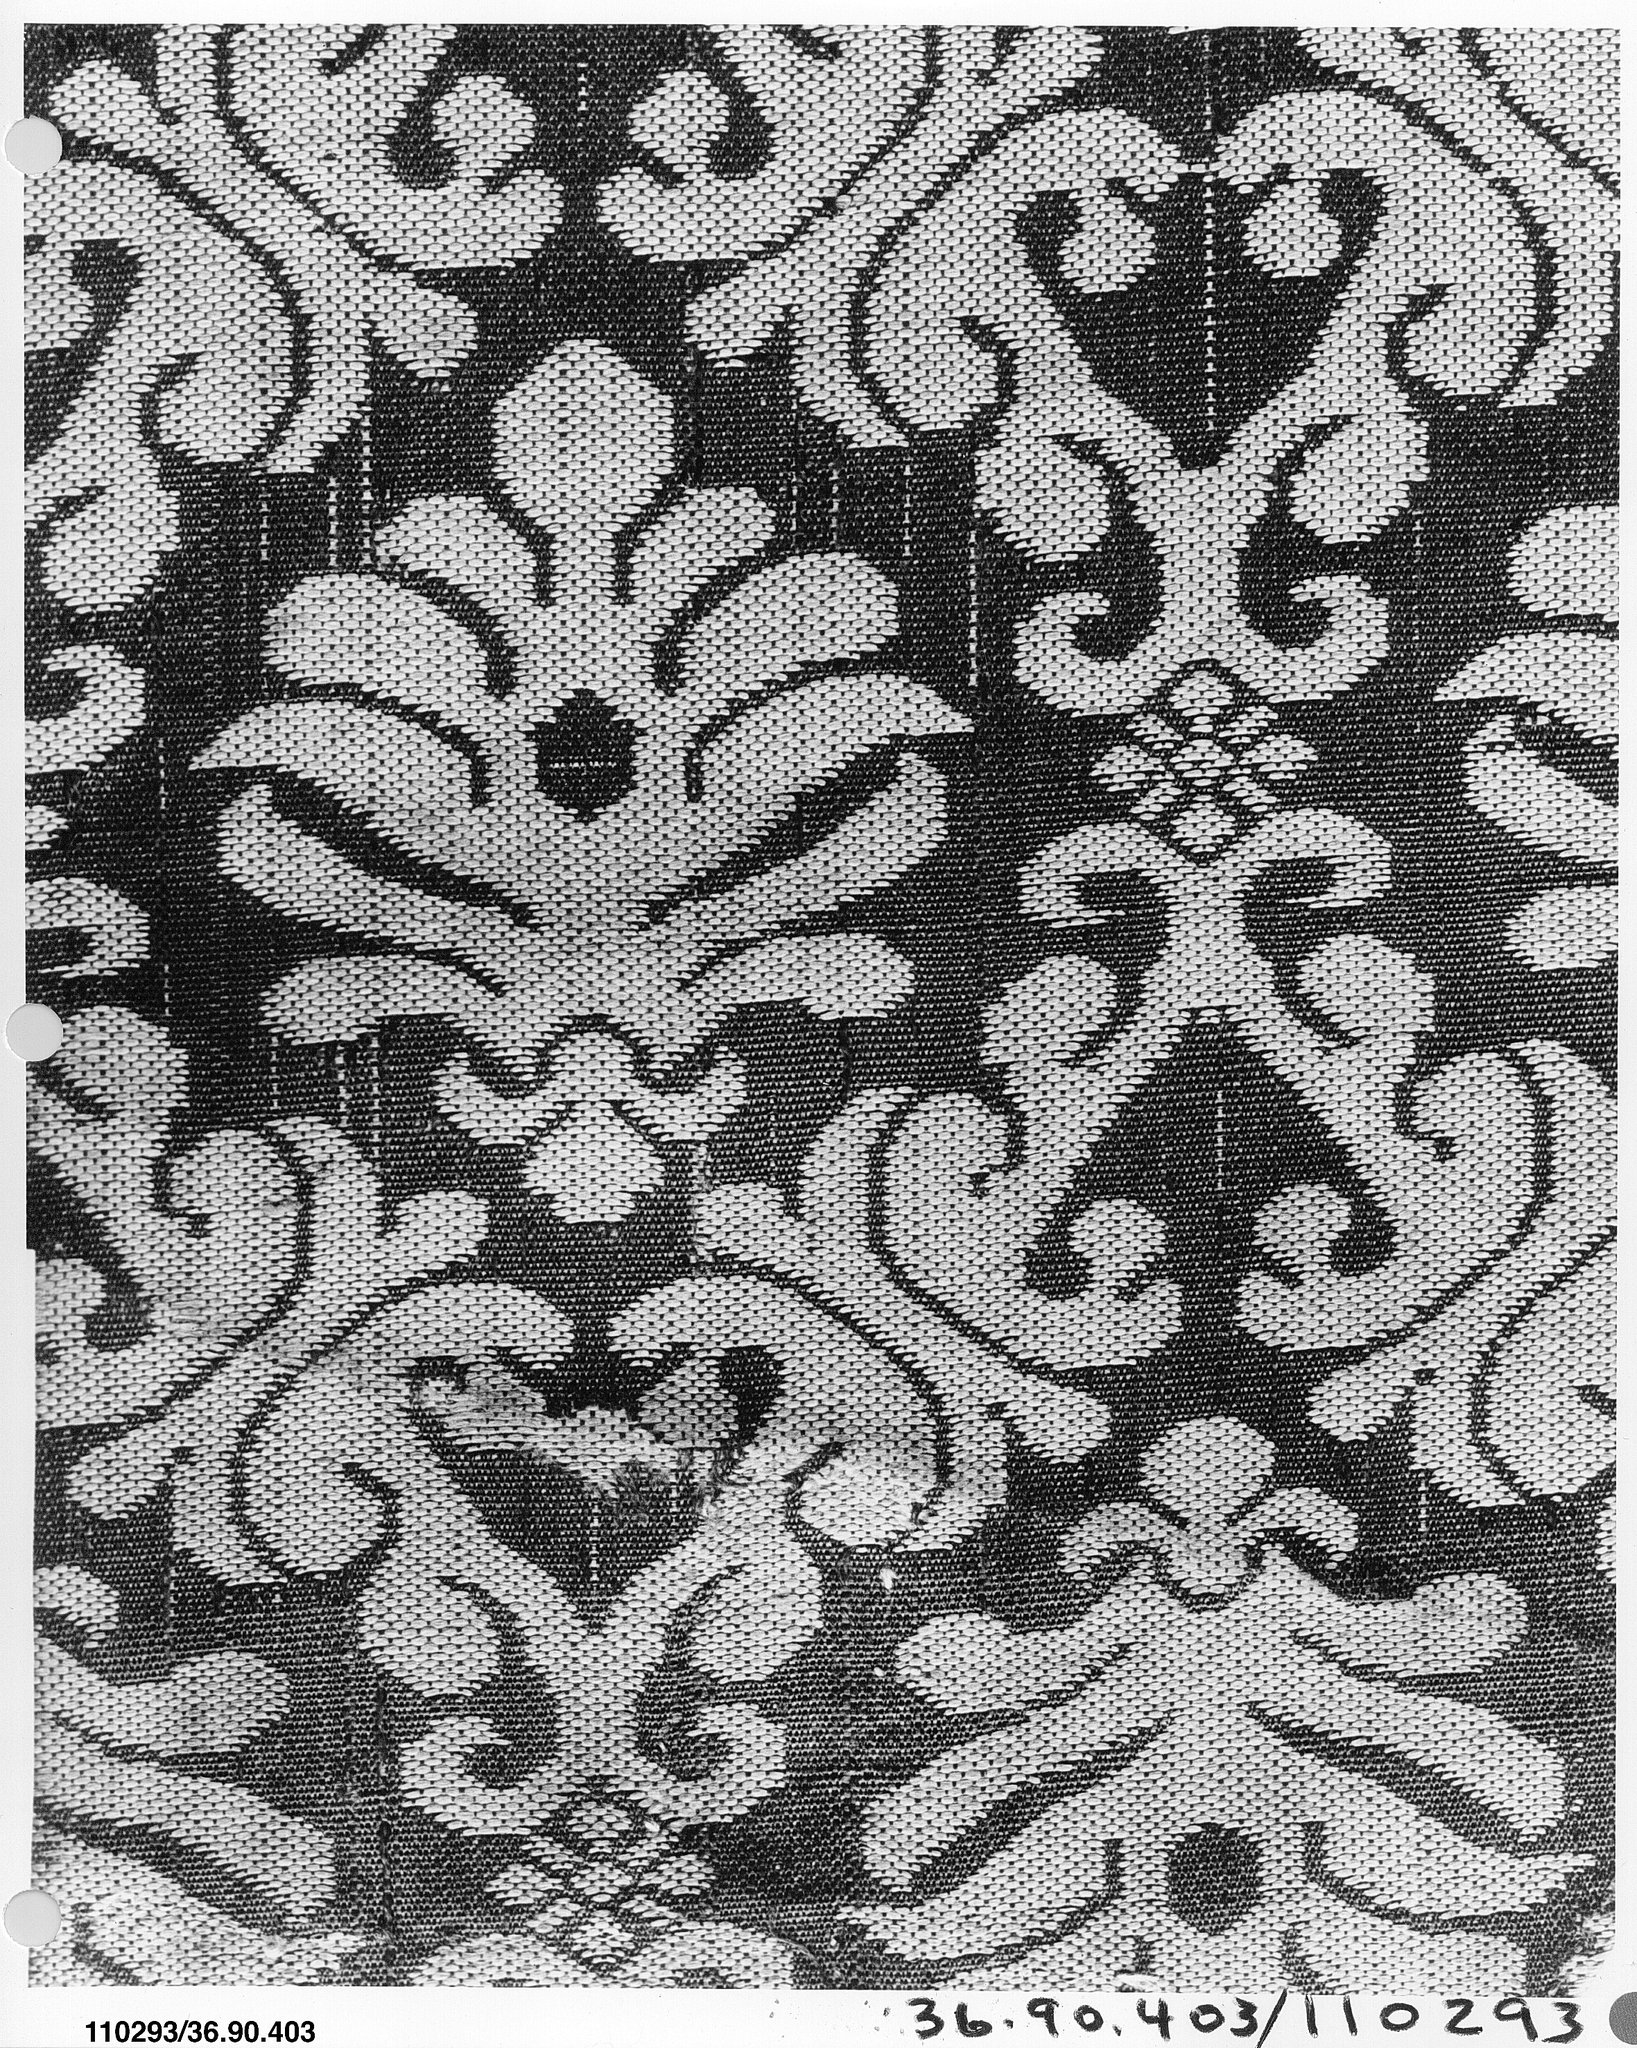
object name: piece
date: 1501-1600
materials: silk